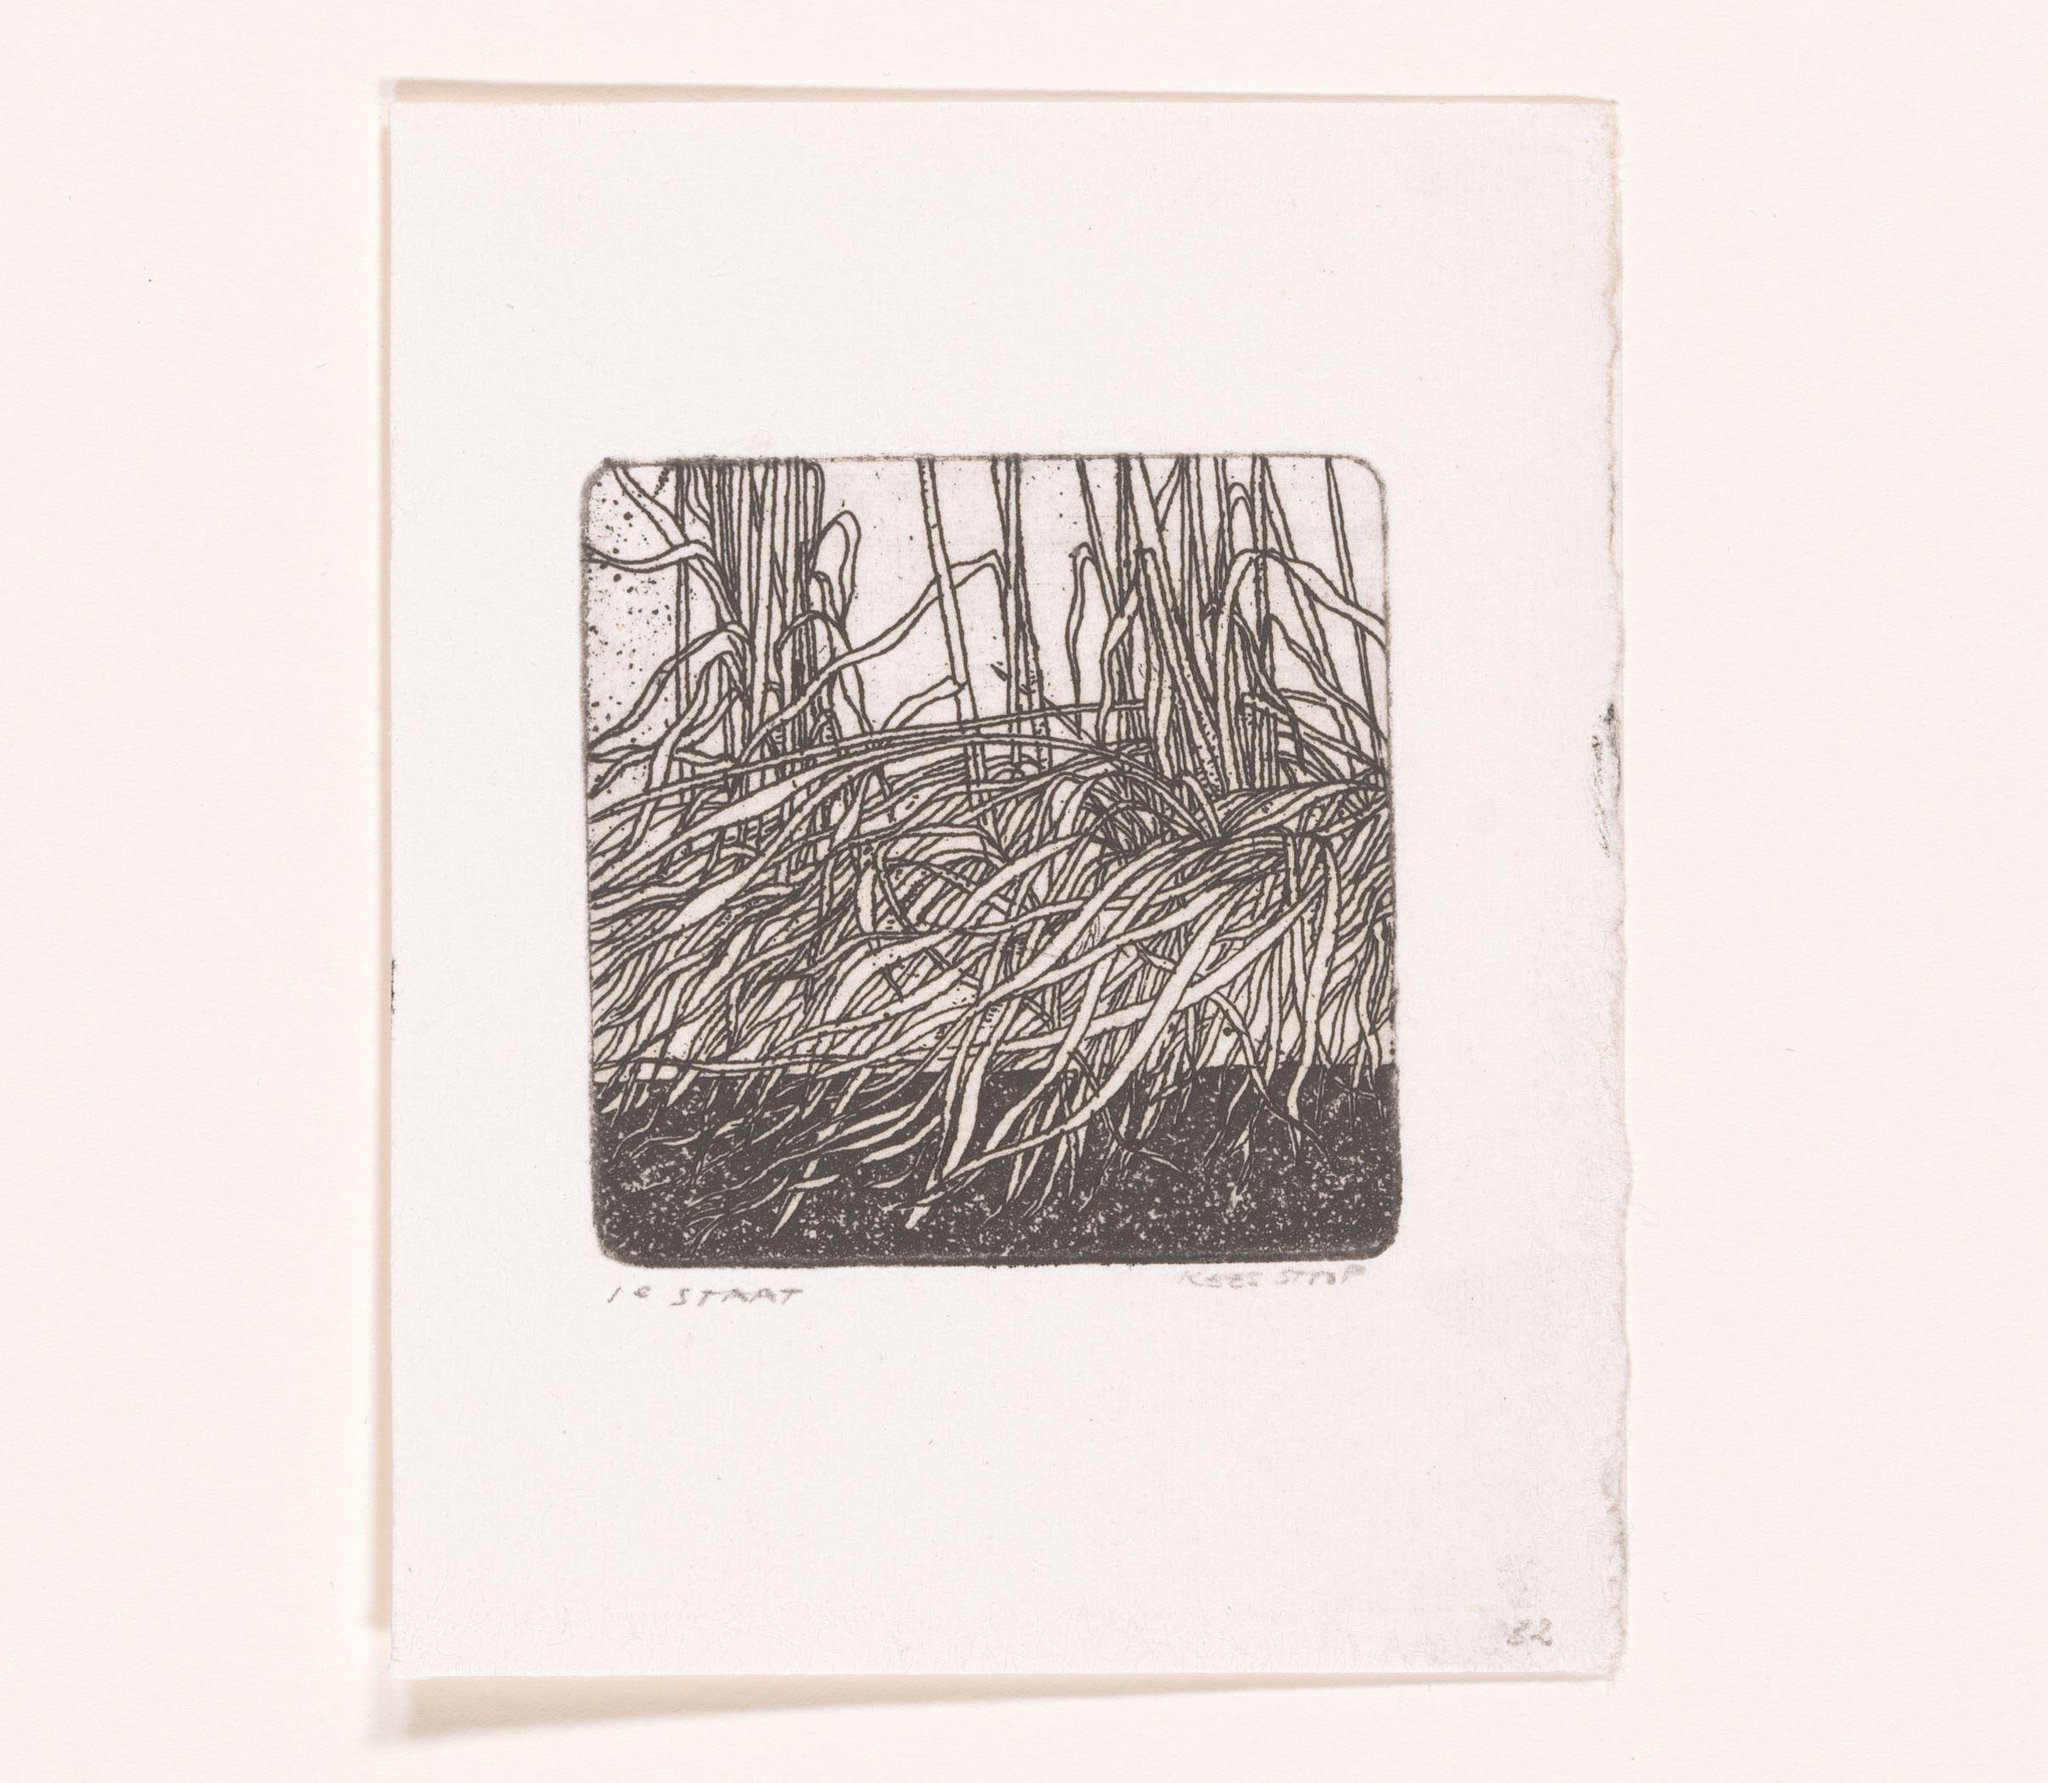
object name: print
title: Grashalmen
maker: kees stoop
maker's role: draughtsman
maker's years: 1929-2019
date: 1944-1990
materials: paper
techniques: etching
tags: plants and herbs: grass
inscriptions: inscription: ‘1e STAAT’, signature: ‘KEES STOOP’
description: Grashalmen, de wortels zichtbaar in de aarde.